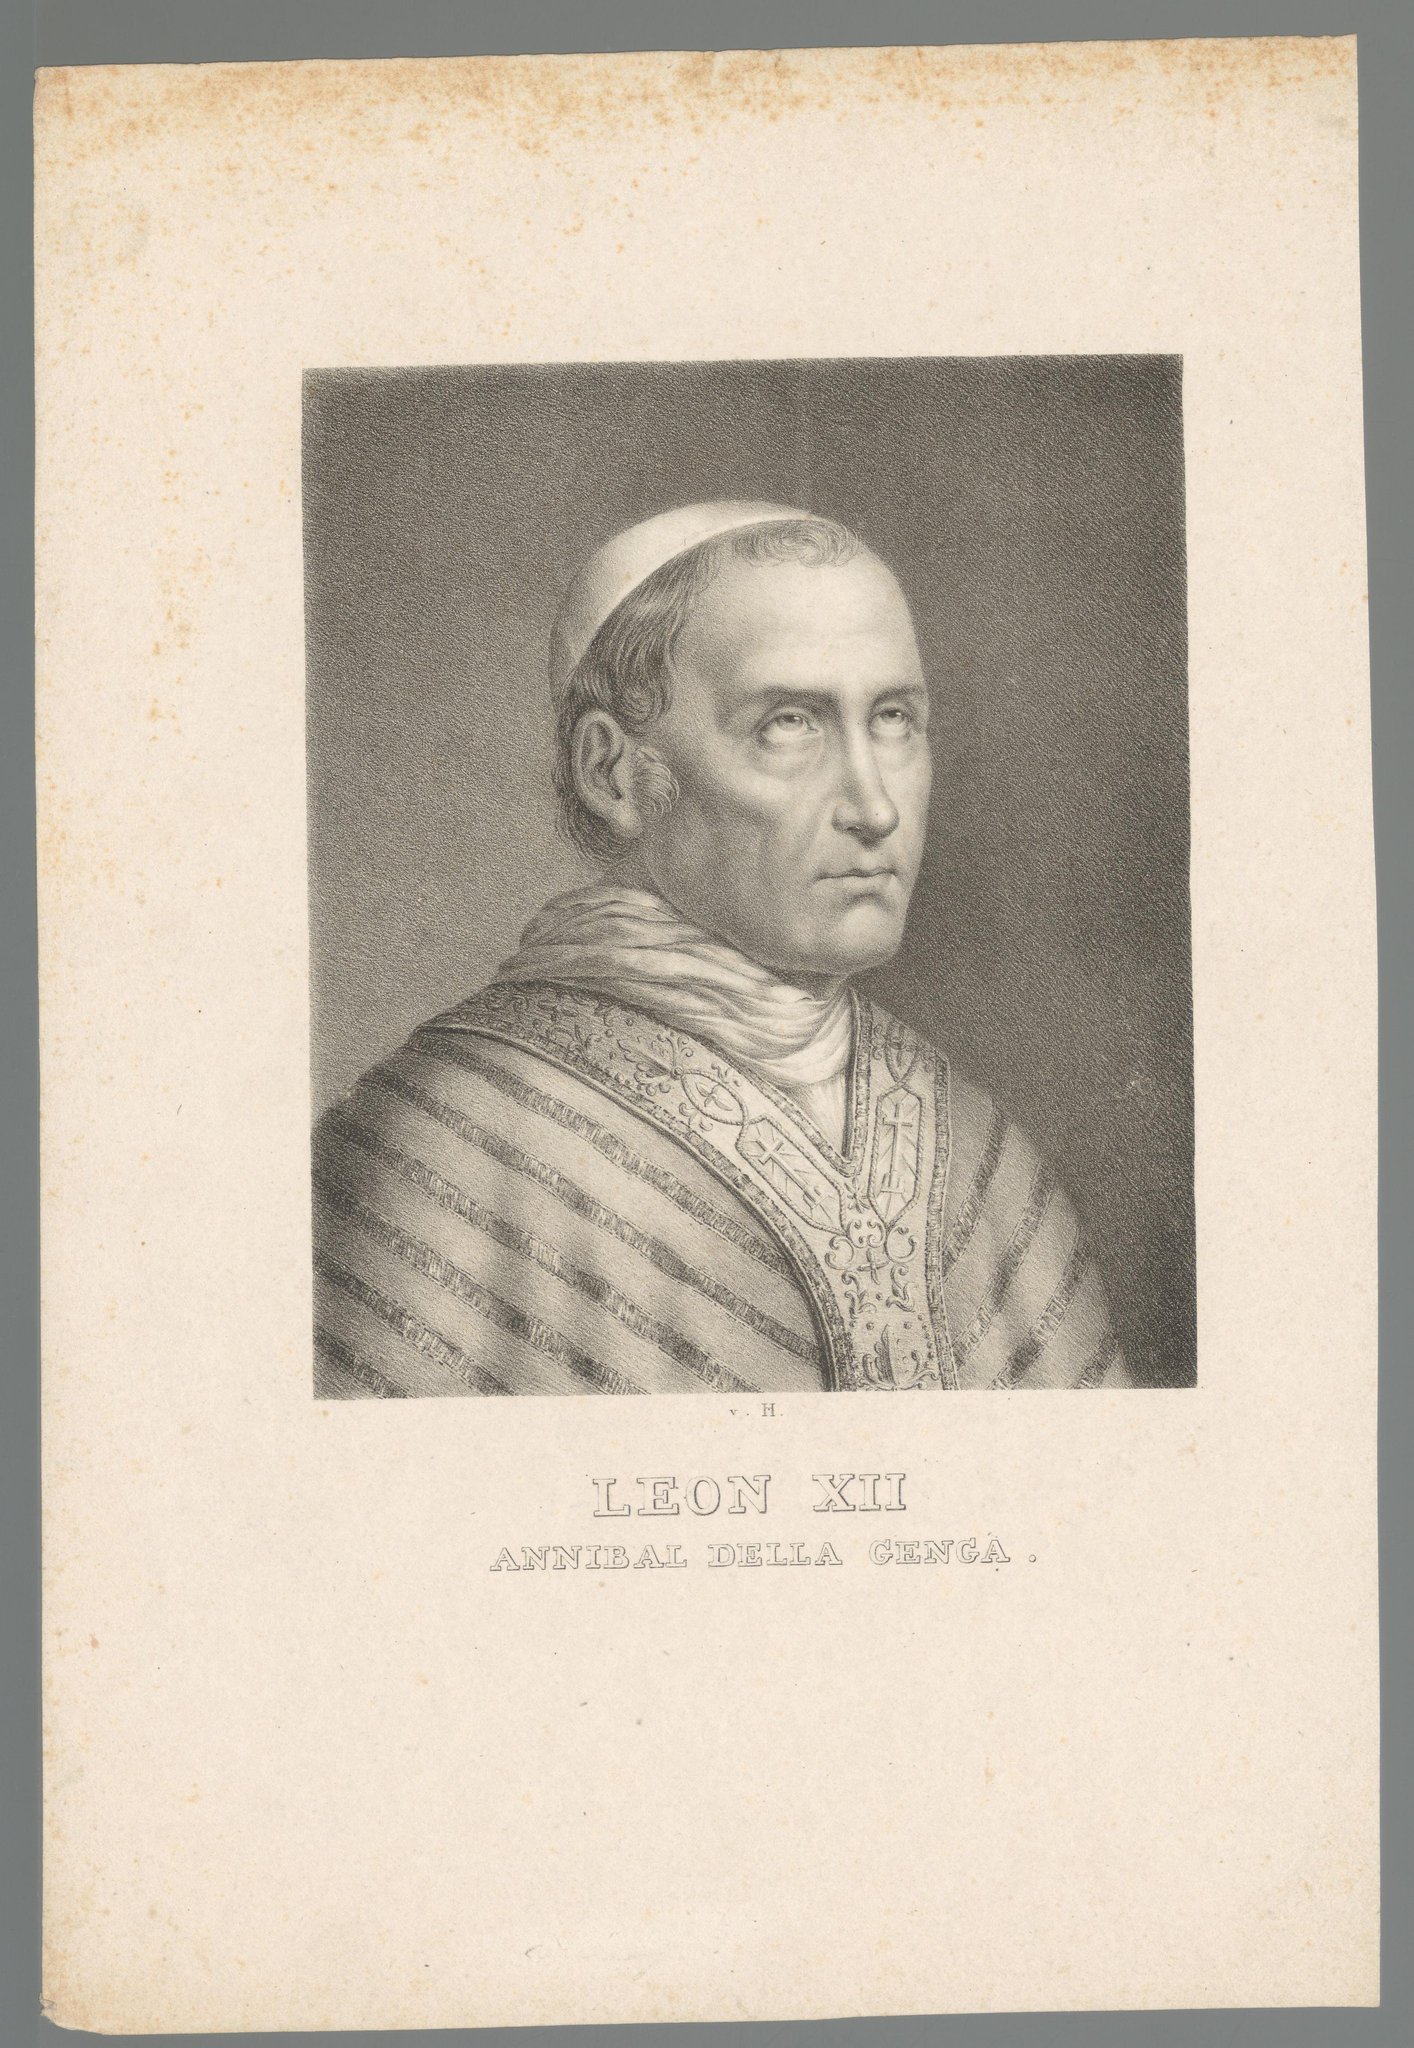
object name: print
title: Portret van Leo XII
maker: monogrammist vh (19e eeuw)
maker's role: print maker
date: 1820-1860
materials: paper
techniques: lithograph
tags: rome, adult man, historical persons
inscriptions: collector's mark: Lugt 2228